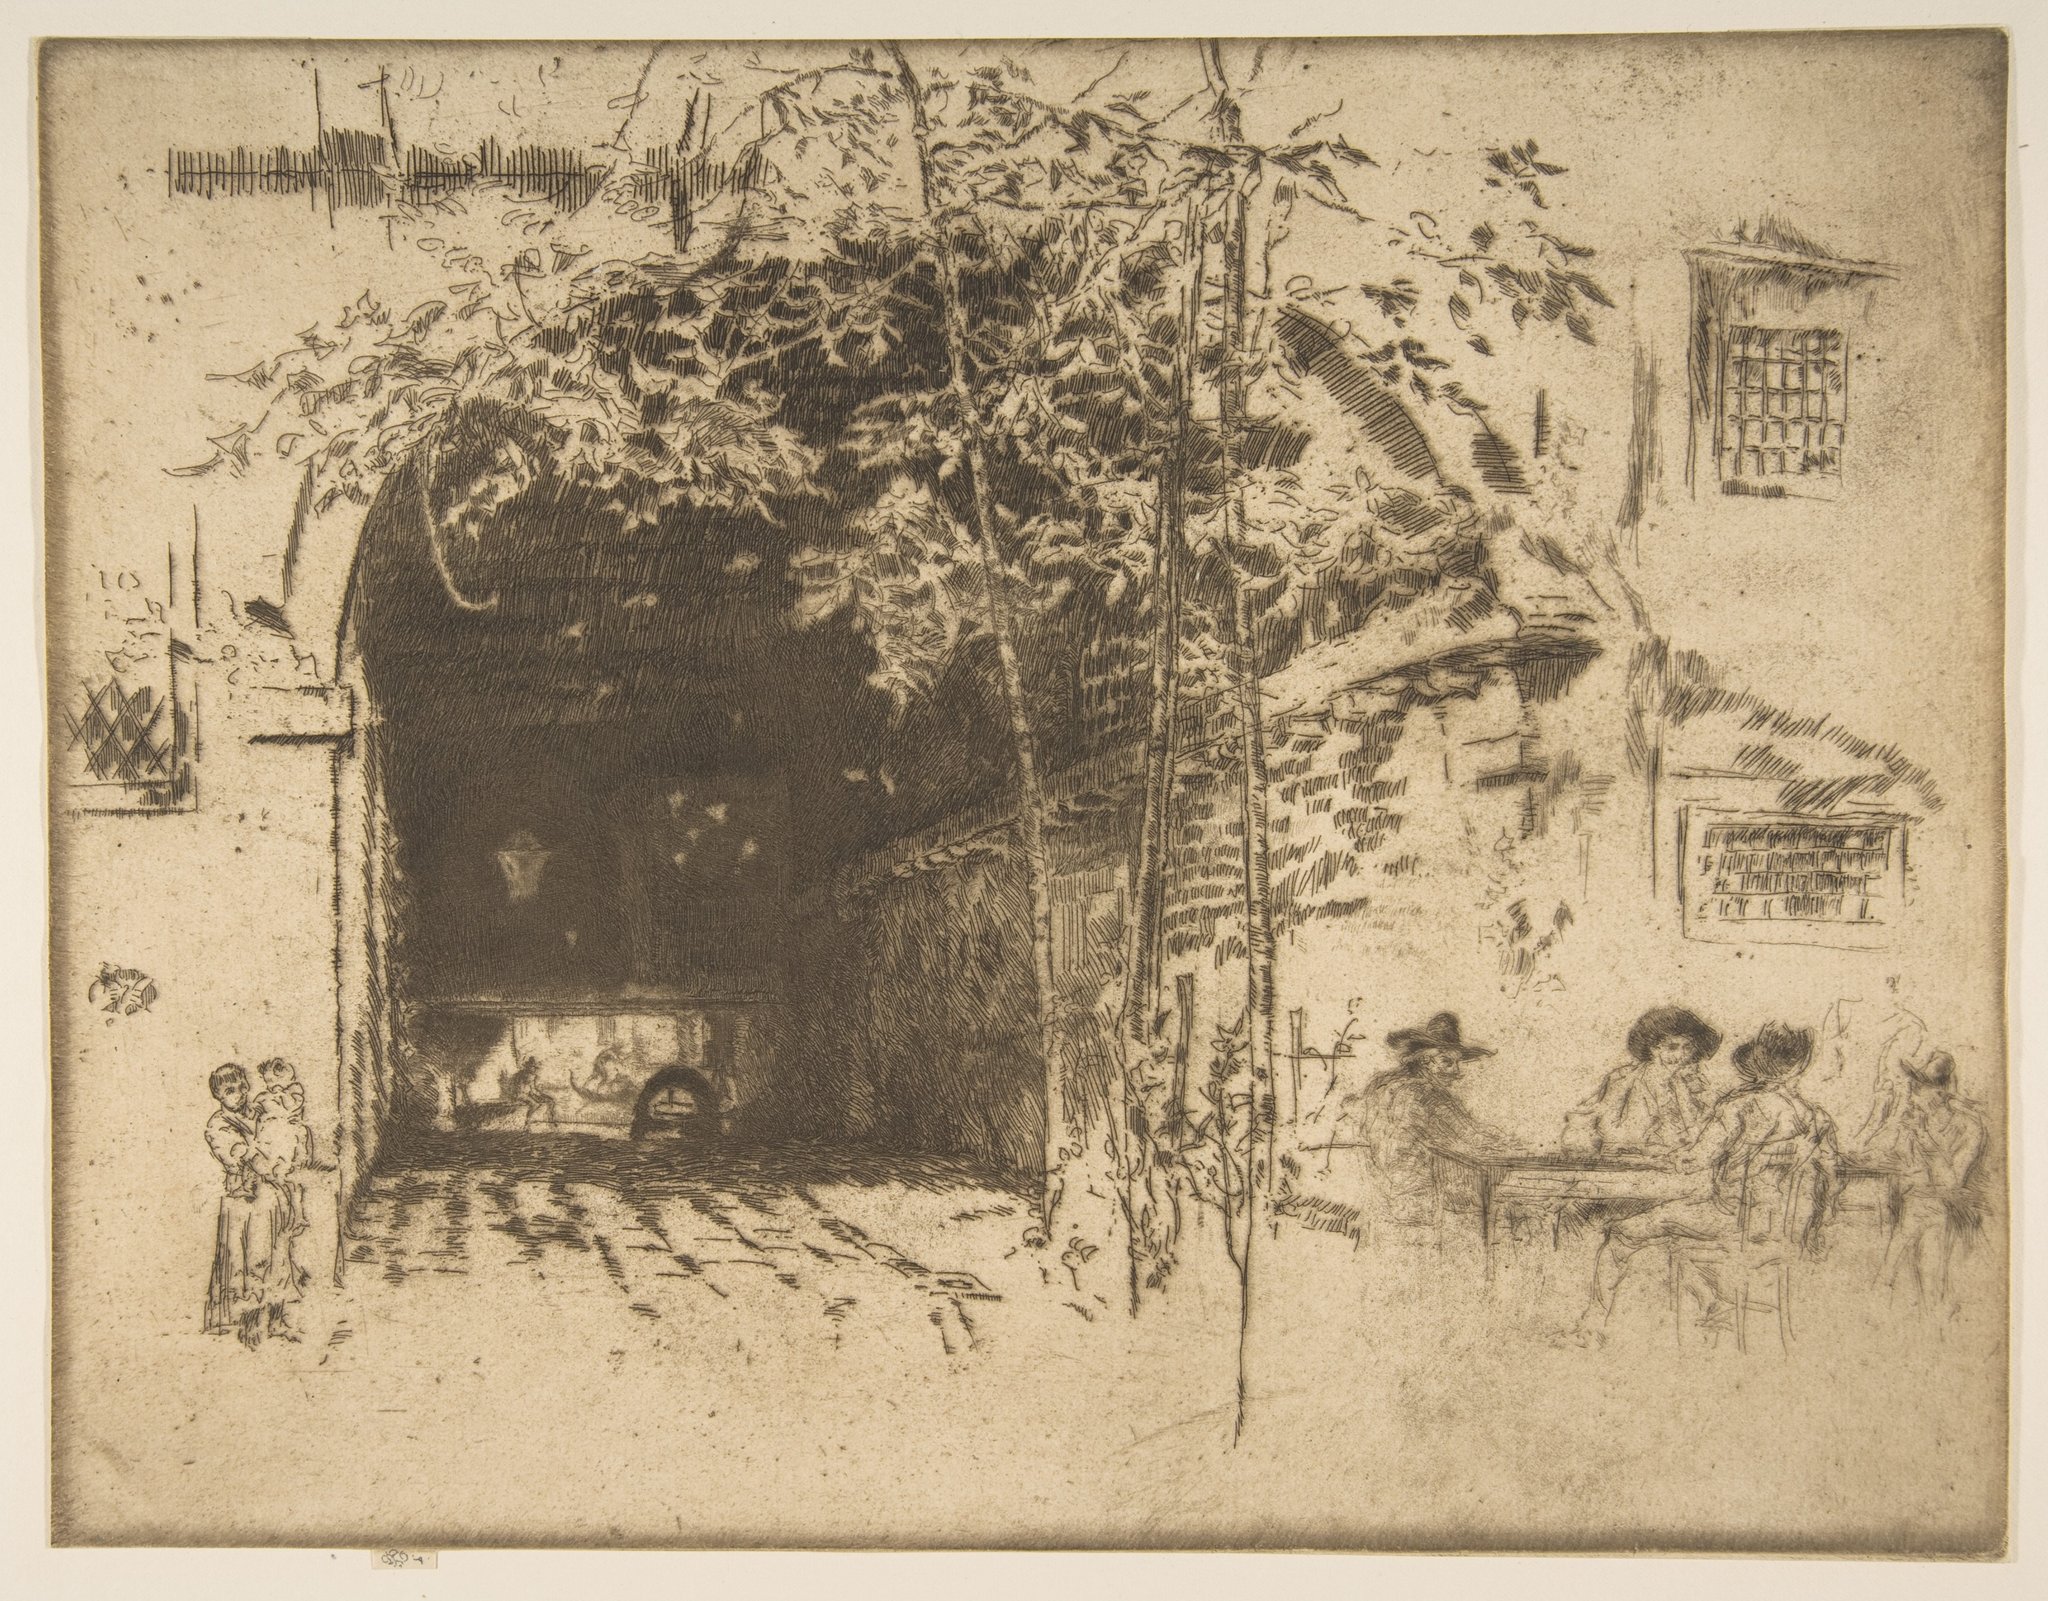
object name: print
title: The Traghetto, No. 2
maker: james mcneill whistler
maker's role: artist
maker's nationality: american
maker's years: 1834-1903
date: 1879-1880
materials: ink, paper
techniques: drypoint, etching, printing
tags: courtyards,men,venice